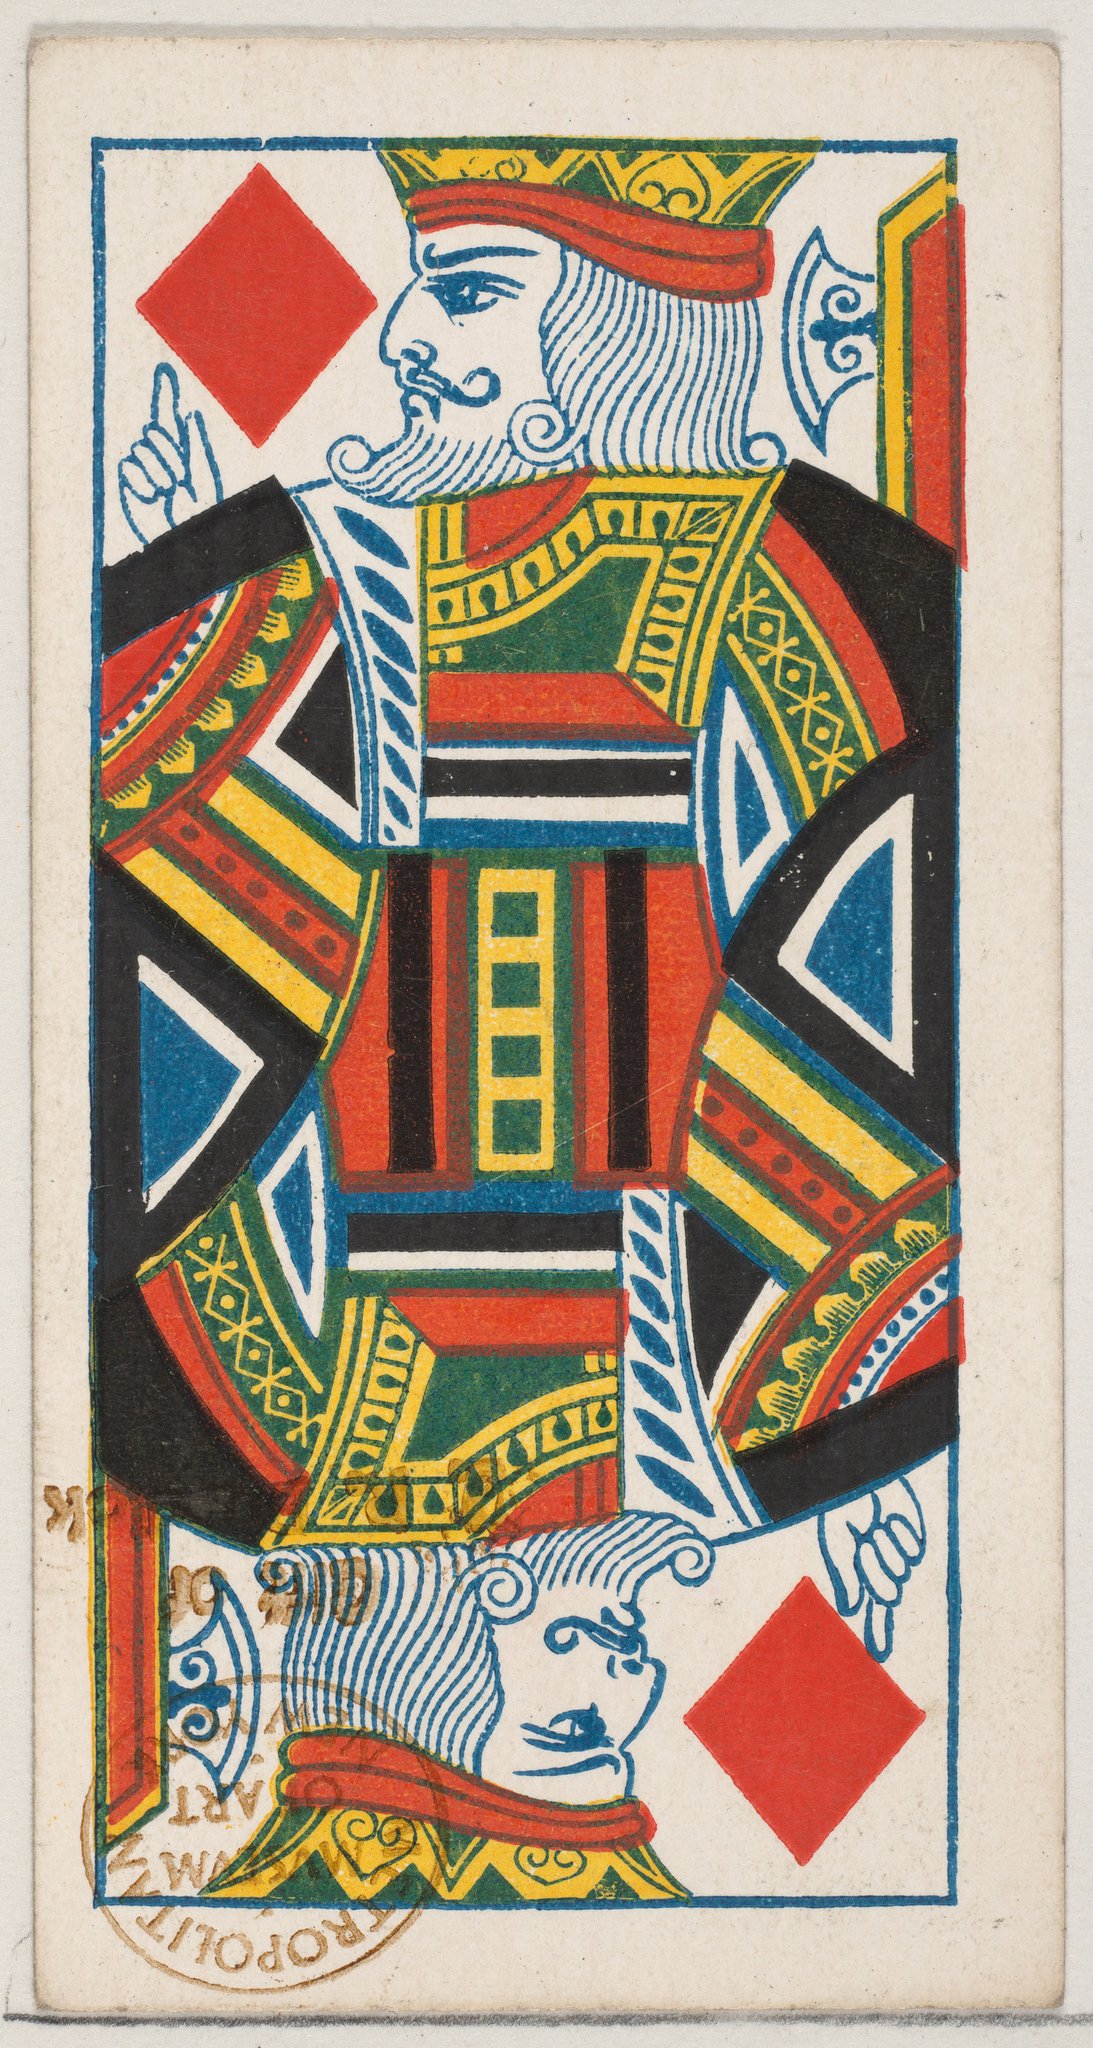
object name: print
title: King of Diamonds, from the Playing Cards series (N84) to promote Turkish Cross-Cut Cigarettes for W. Duke, Sons and Co.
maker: w. duke, sons & co.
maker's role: publisher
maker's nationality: american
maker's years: 1870-1920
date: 1888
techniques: color lithograph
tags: playing cards